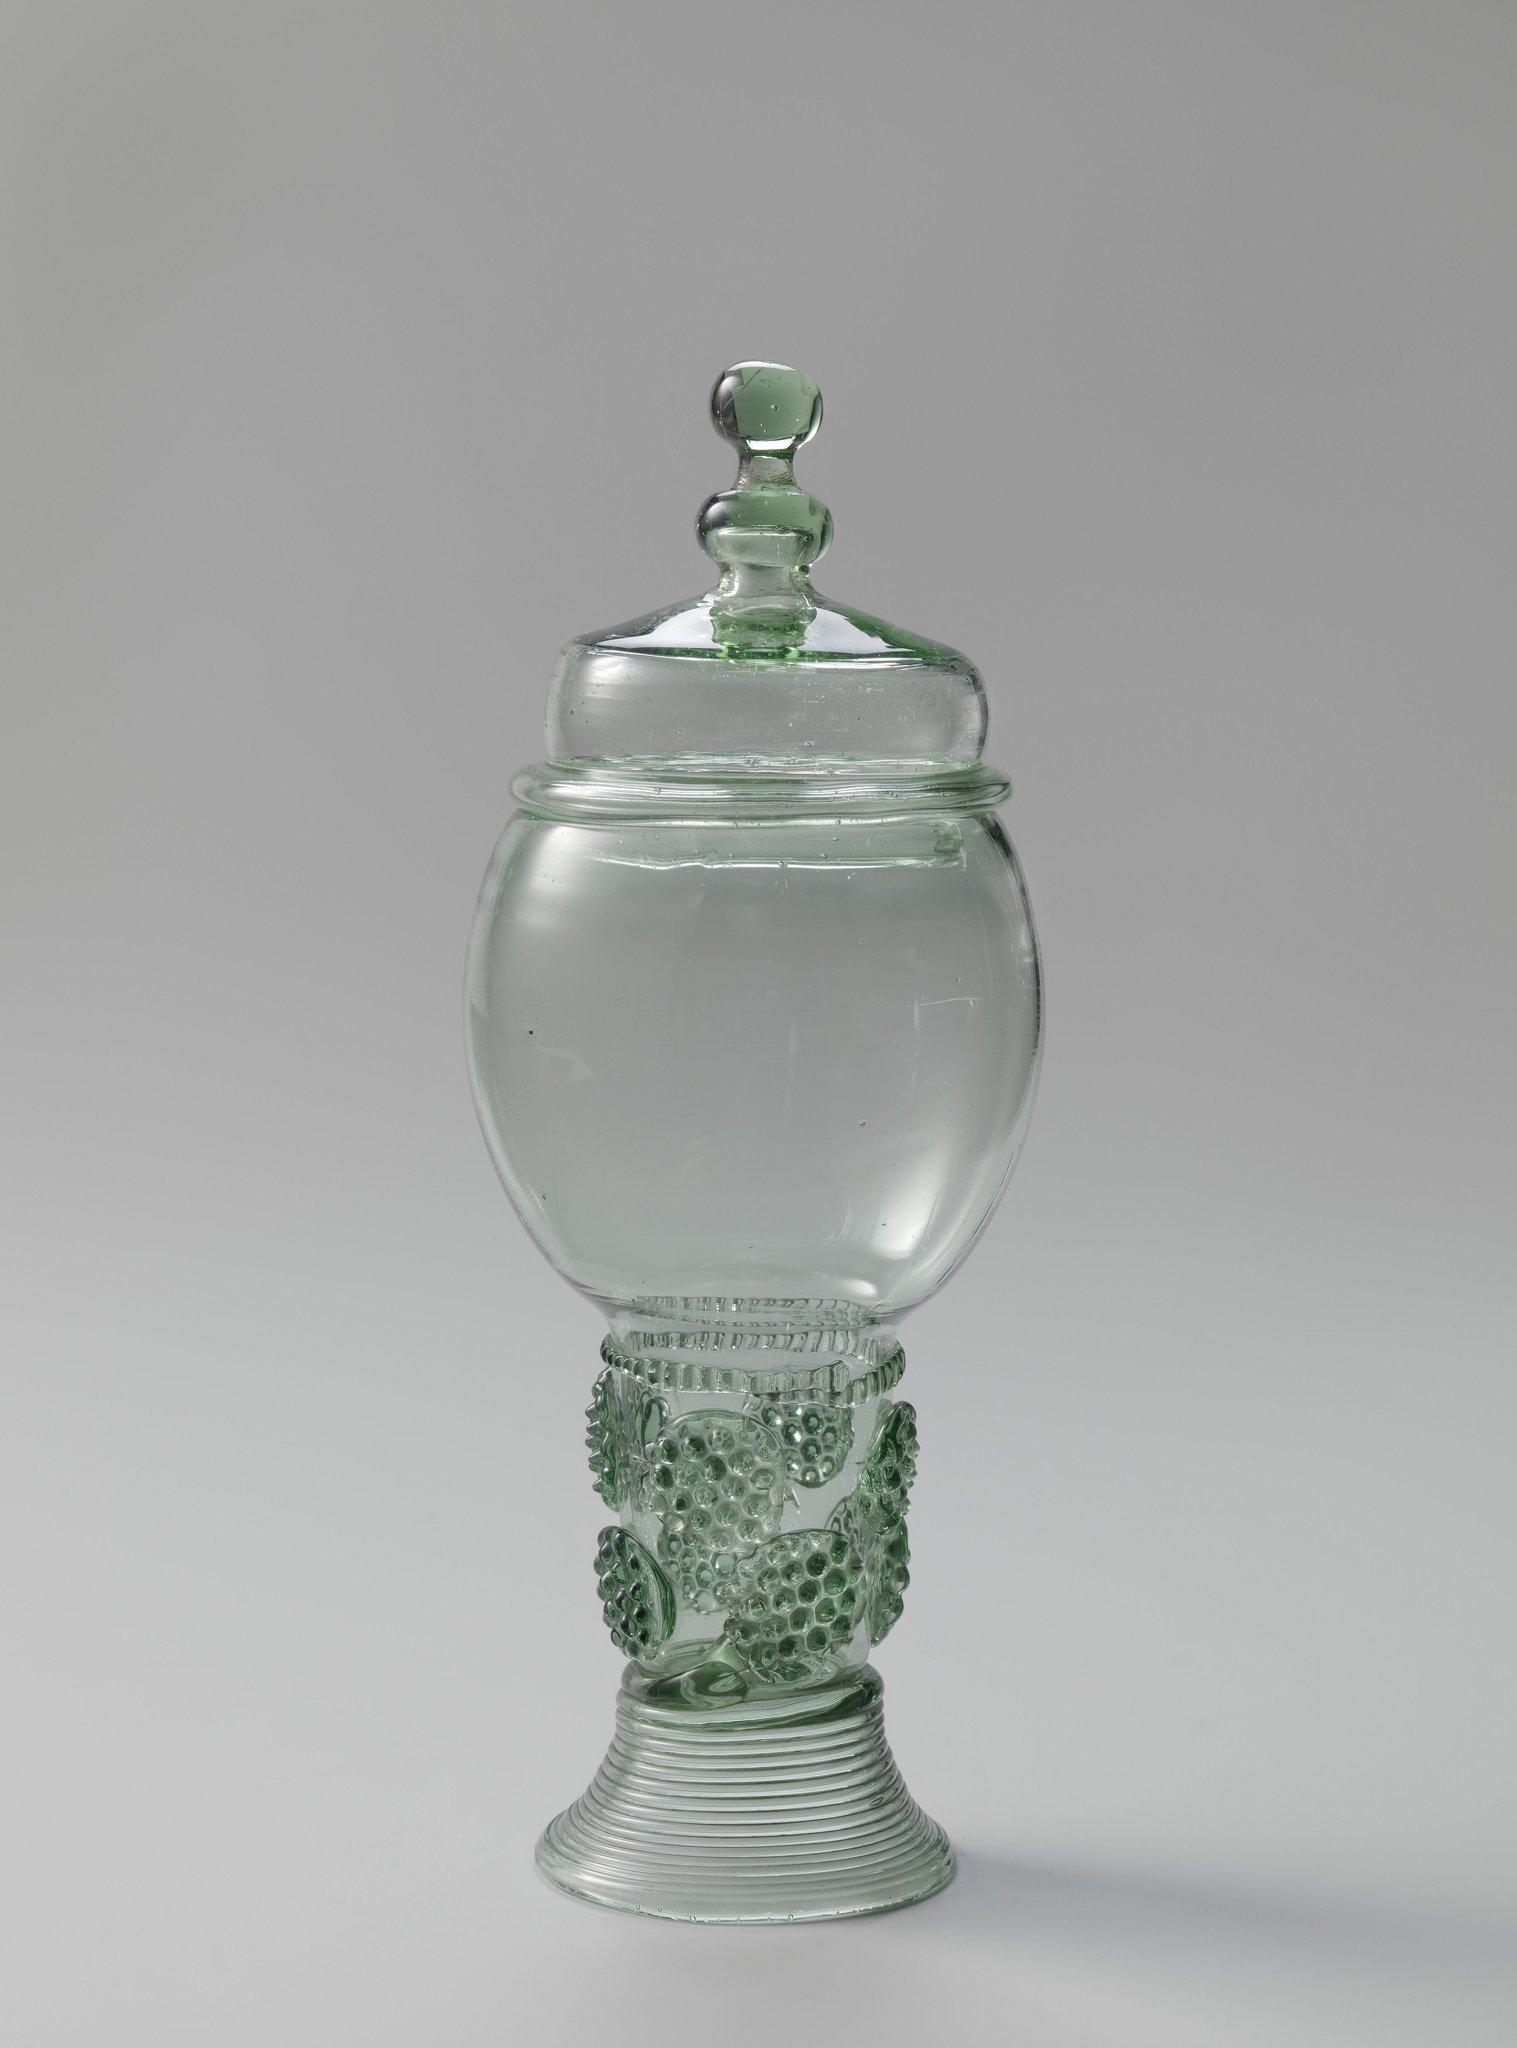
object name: roemer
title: Lidded roemer with two rows of raspberry prunts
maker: Anonymous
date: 1690-1800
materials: glass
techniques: glassblowing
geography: germany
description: The Netherlands or Germany, c. 1690–1800 glass